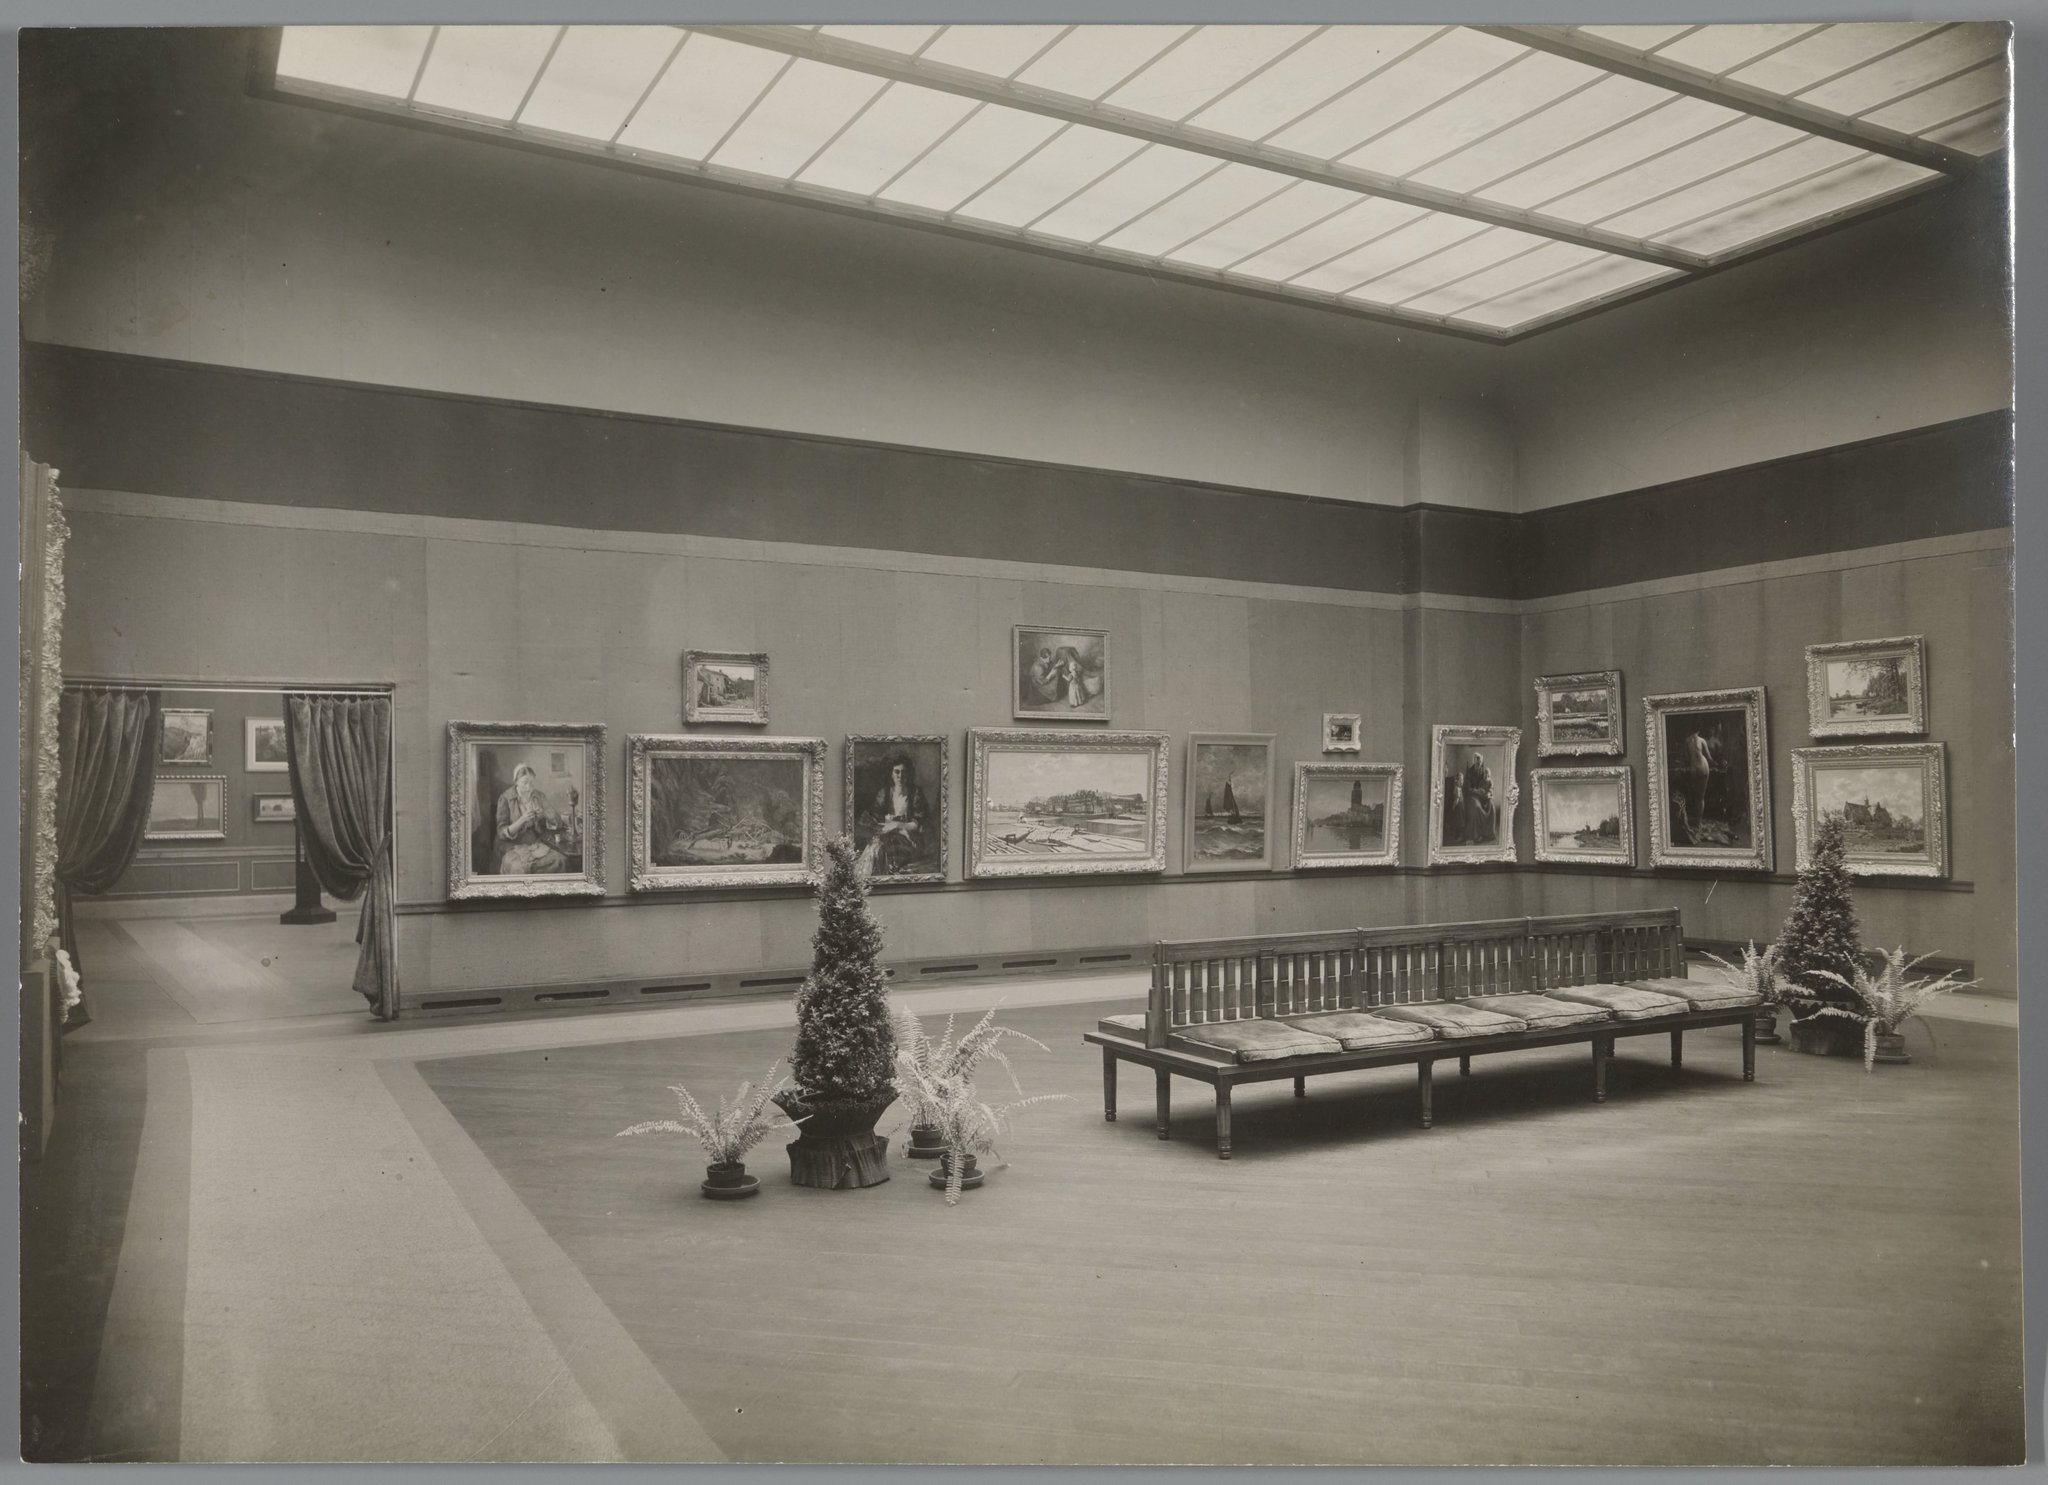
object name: photograph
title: Nederlandse zalen op de Panama-Pacific International exposition te San Francisco, 1915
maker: gabriel moulin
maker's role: fotograaf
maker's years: 1872-1945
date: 1915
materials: paper, photographic support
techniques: gelatin silver print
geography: san francisco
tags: san francisco